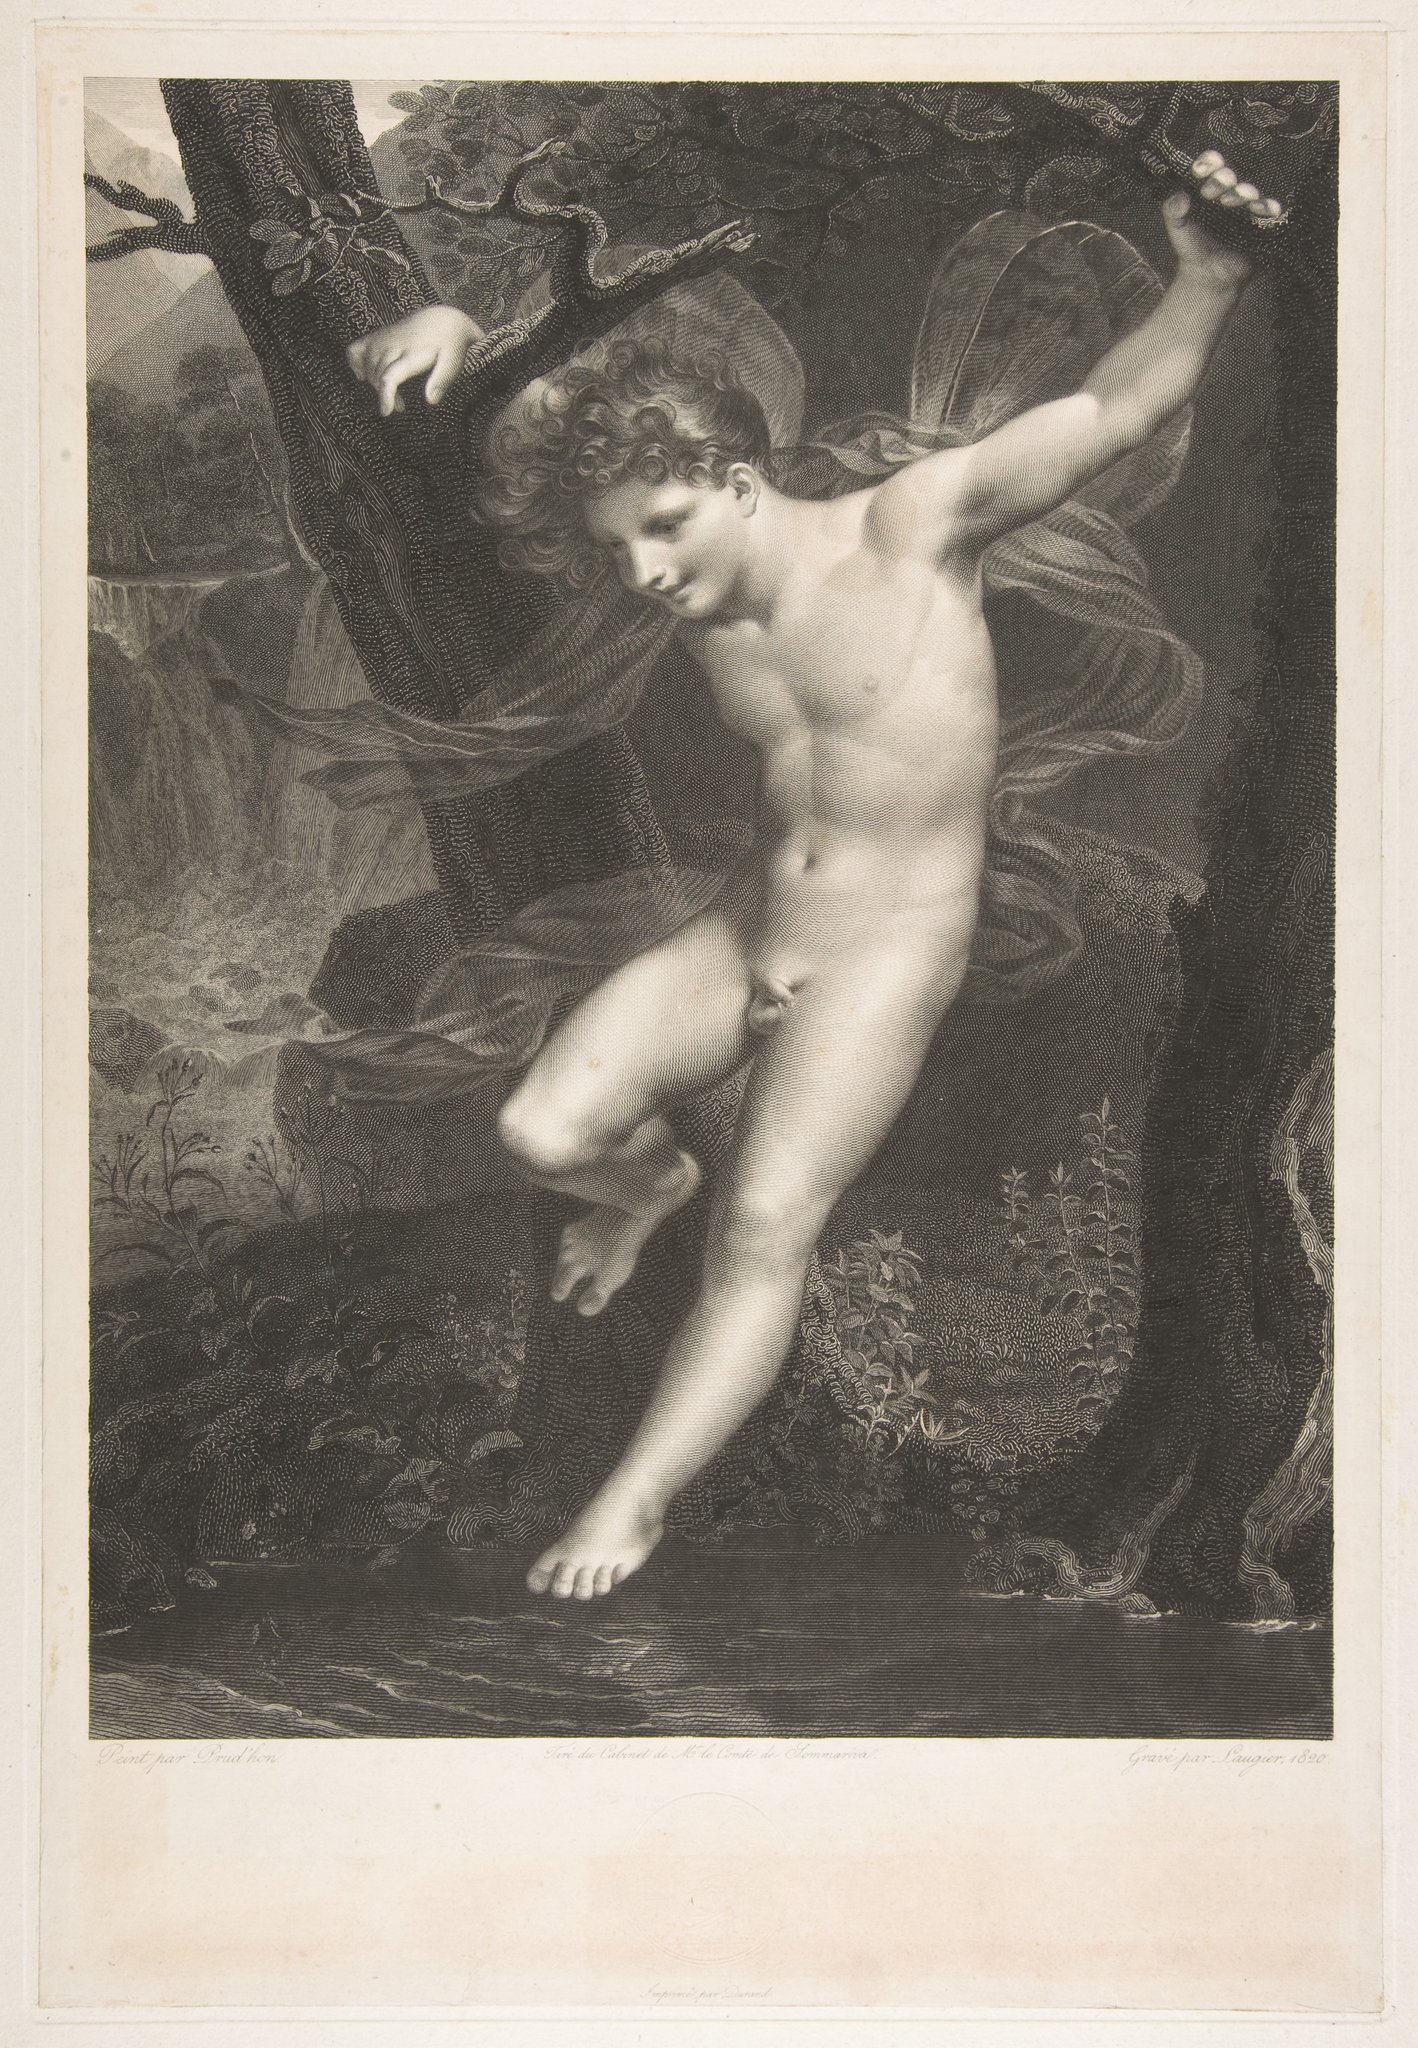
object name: print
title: Zephyr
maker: pierre paul prud'hon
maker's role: artist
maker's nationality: french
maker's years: 1758-1823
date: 1864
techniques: engraving, etching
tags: male nudes